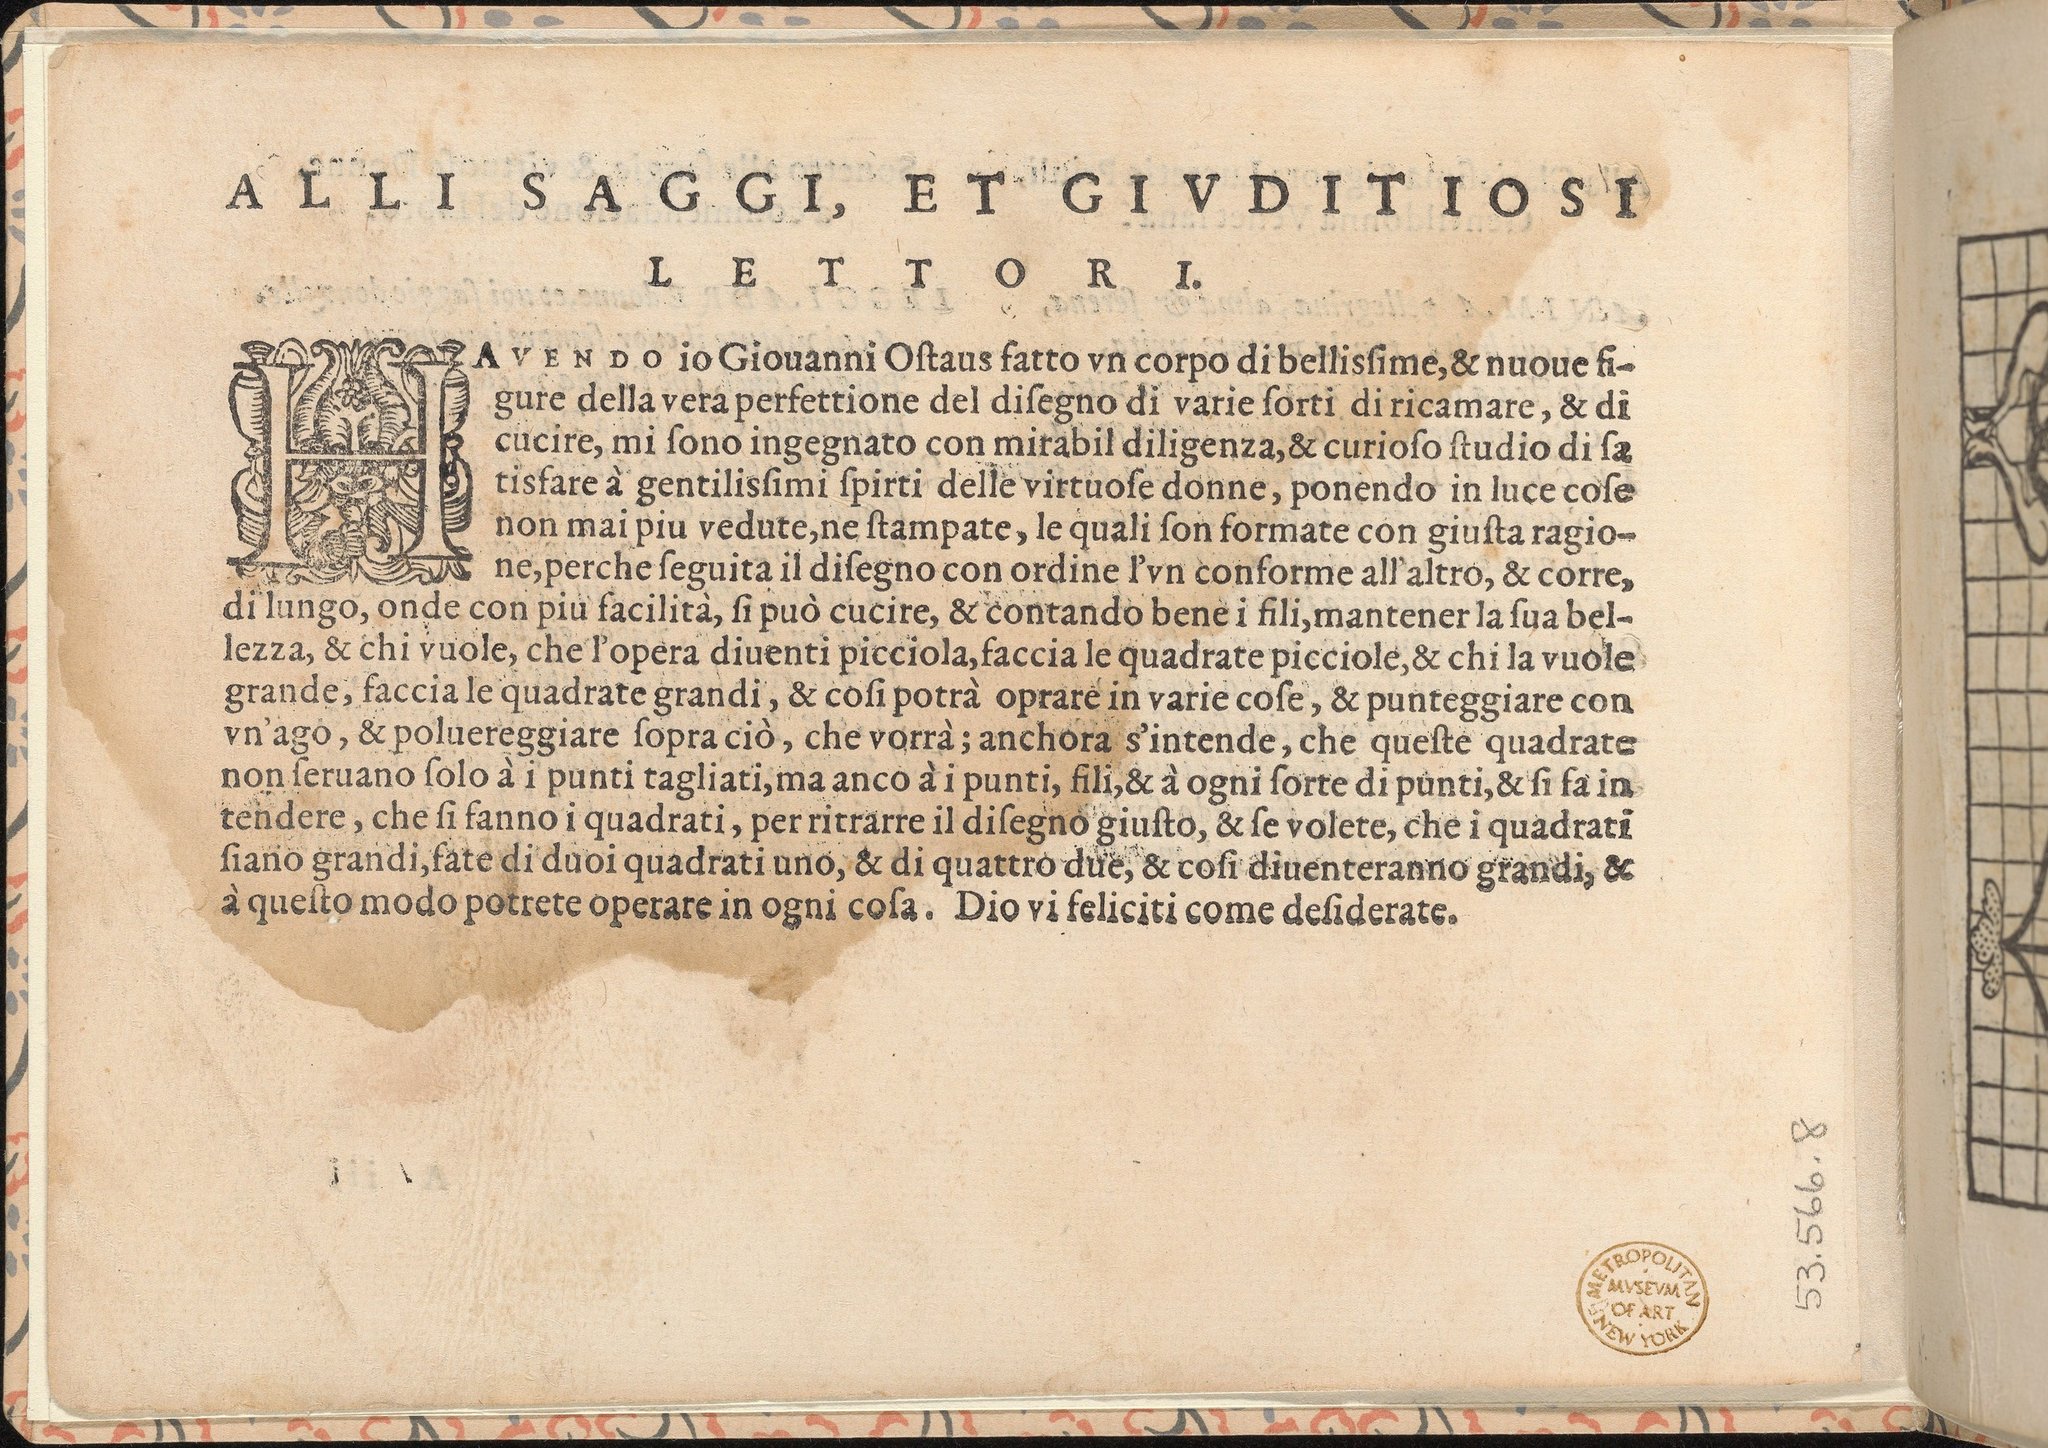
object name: book print ornament architecture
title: La vera perfettione del disegno di varie sorti di recami, page 2 (verso)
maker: giovanni ostaus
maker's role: publisher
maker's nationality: italian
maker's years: 1507-1607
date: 1557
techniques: woodcut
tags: insignia